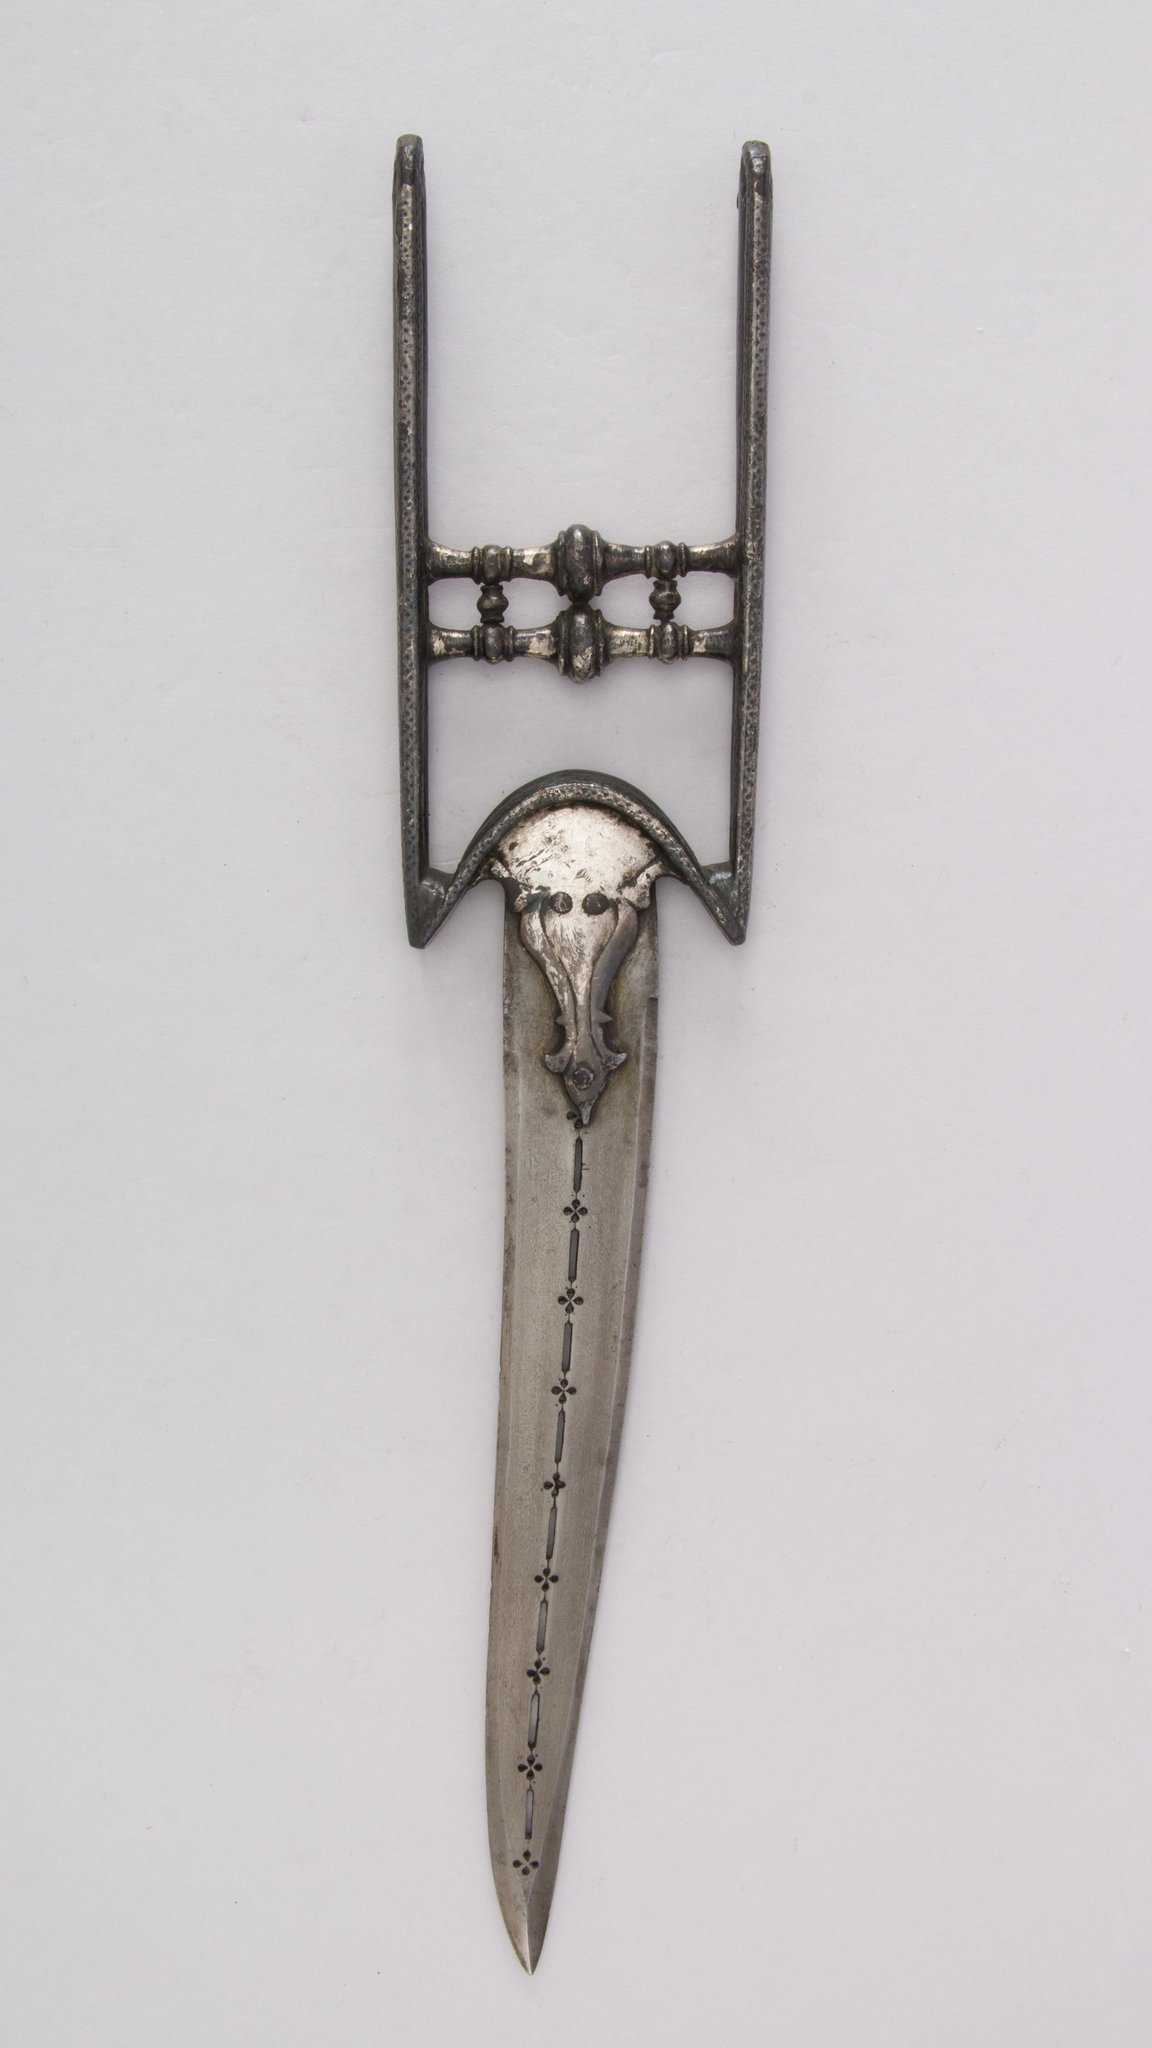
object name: dagger katar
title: Dagger (Katar)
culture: indian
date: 1701-1800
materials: silver, steel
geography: south india